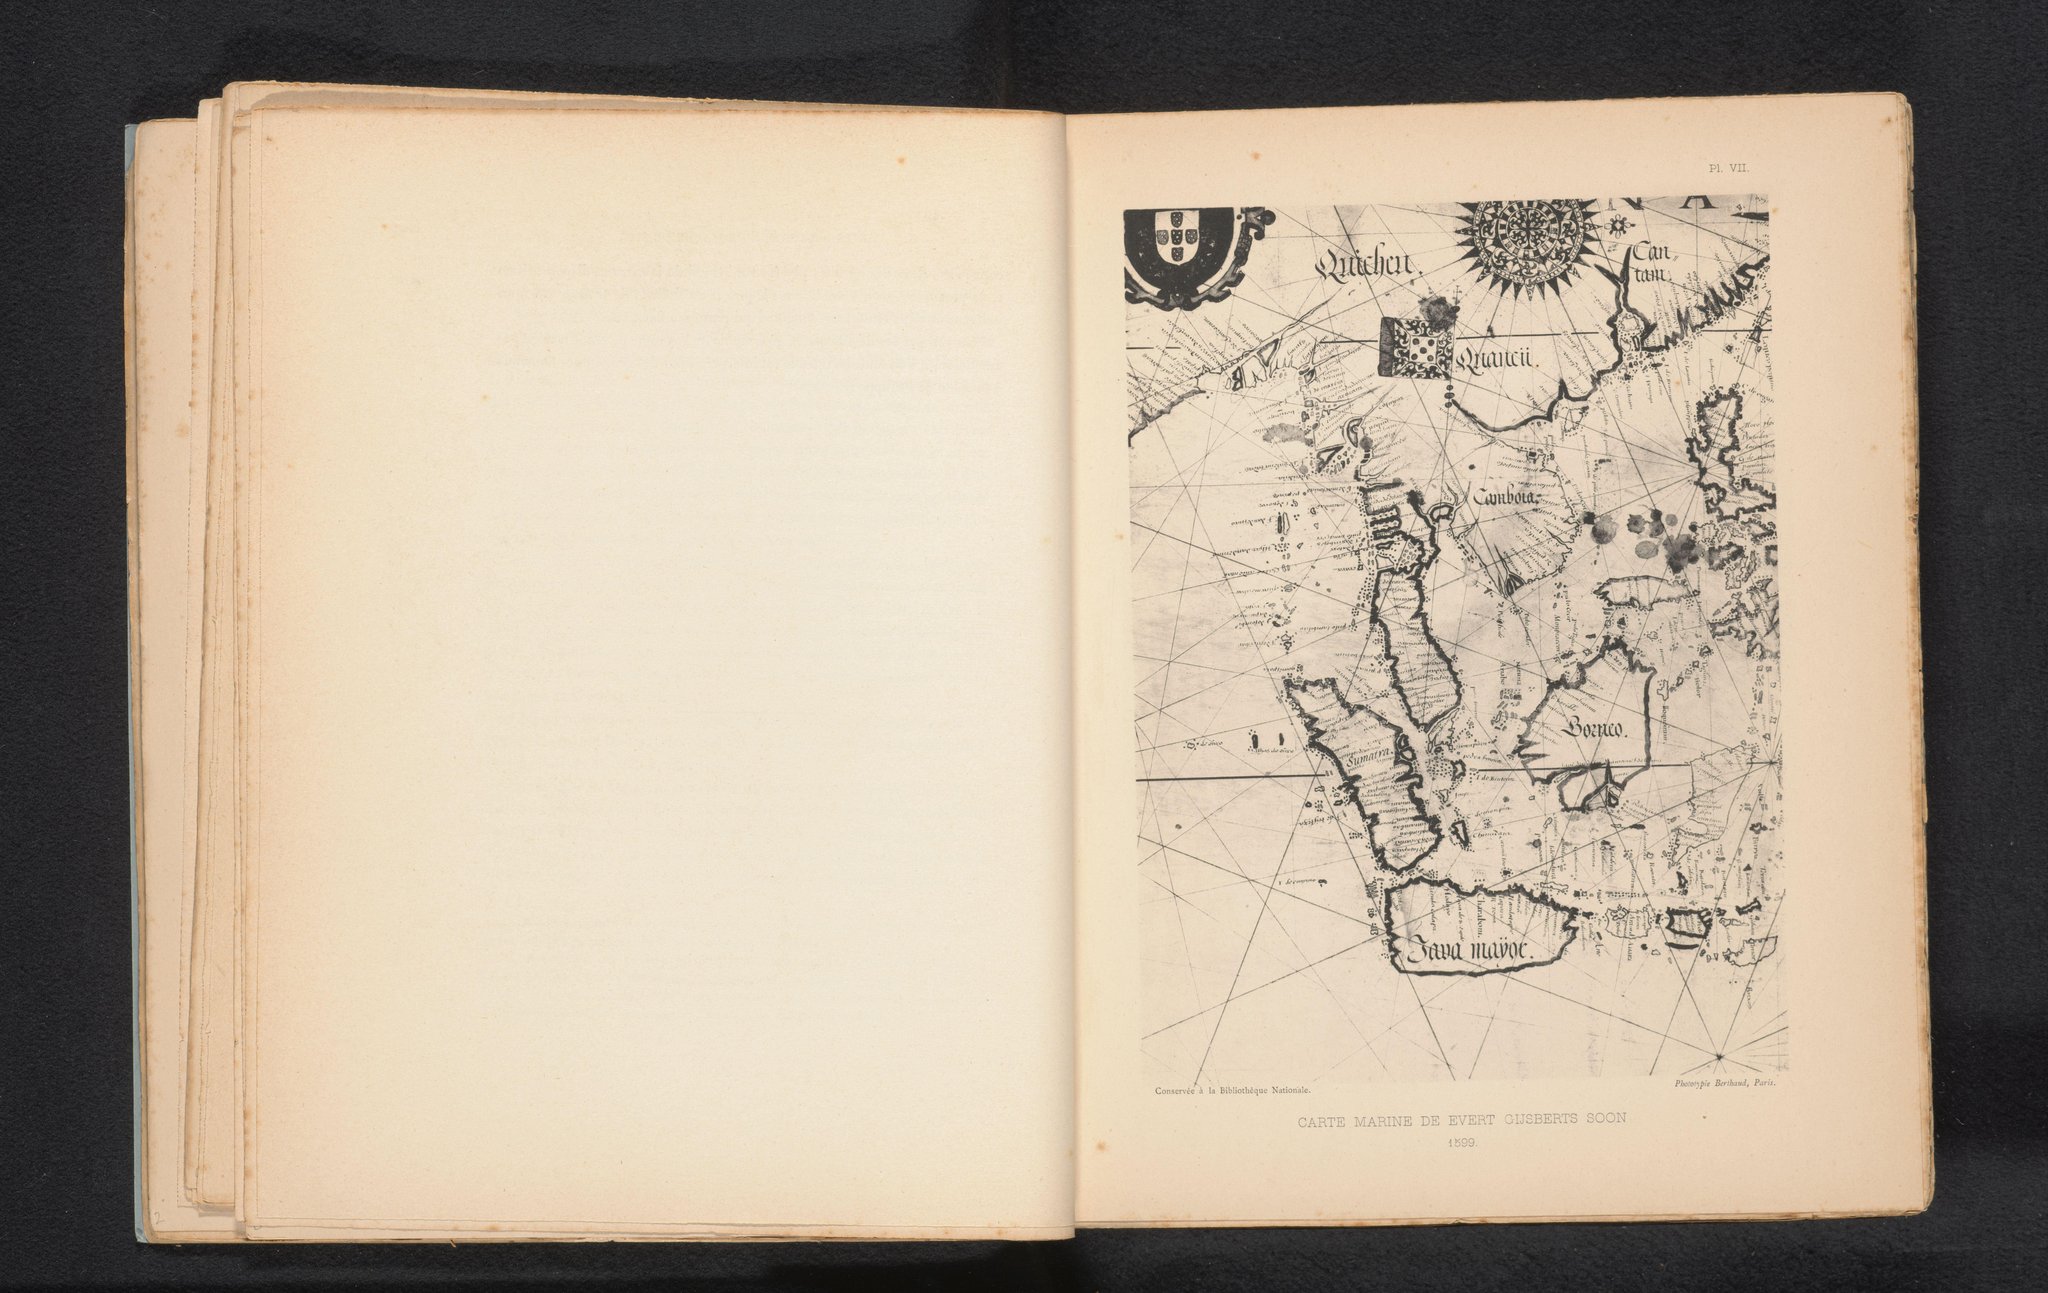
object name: reproduction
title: Carte marine de Evert Gijsberts Soon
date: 1890-1895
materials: paper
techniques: photograph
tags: maps, atlases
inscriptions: inscription: ‘Pl. VII/ Conservée à Bibliothèque Nationale’, inscription: ‘1599’, collector's mark: ‘Société d'Emulation de l'Ain/ Bourg/ Bibliothèque’